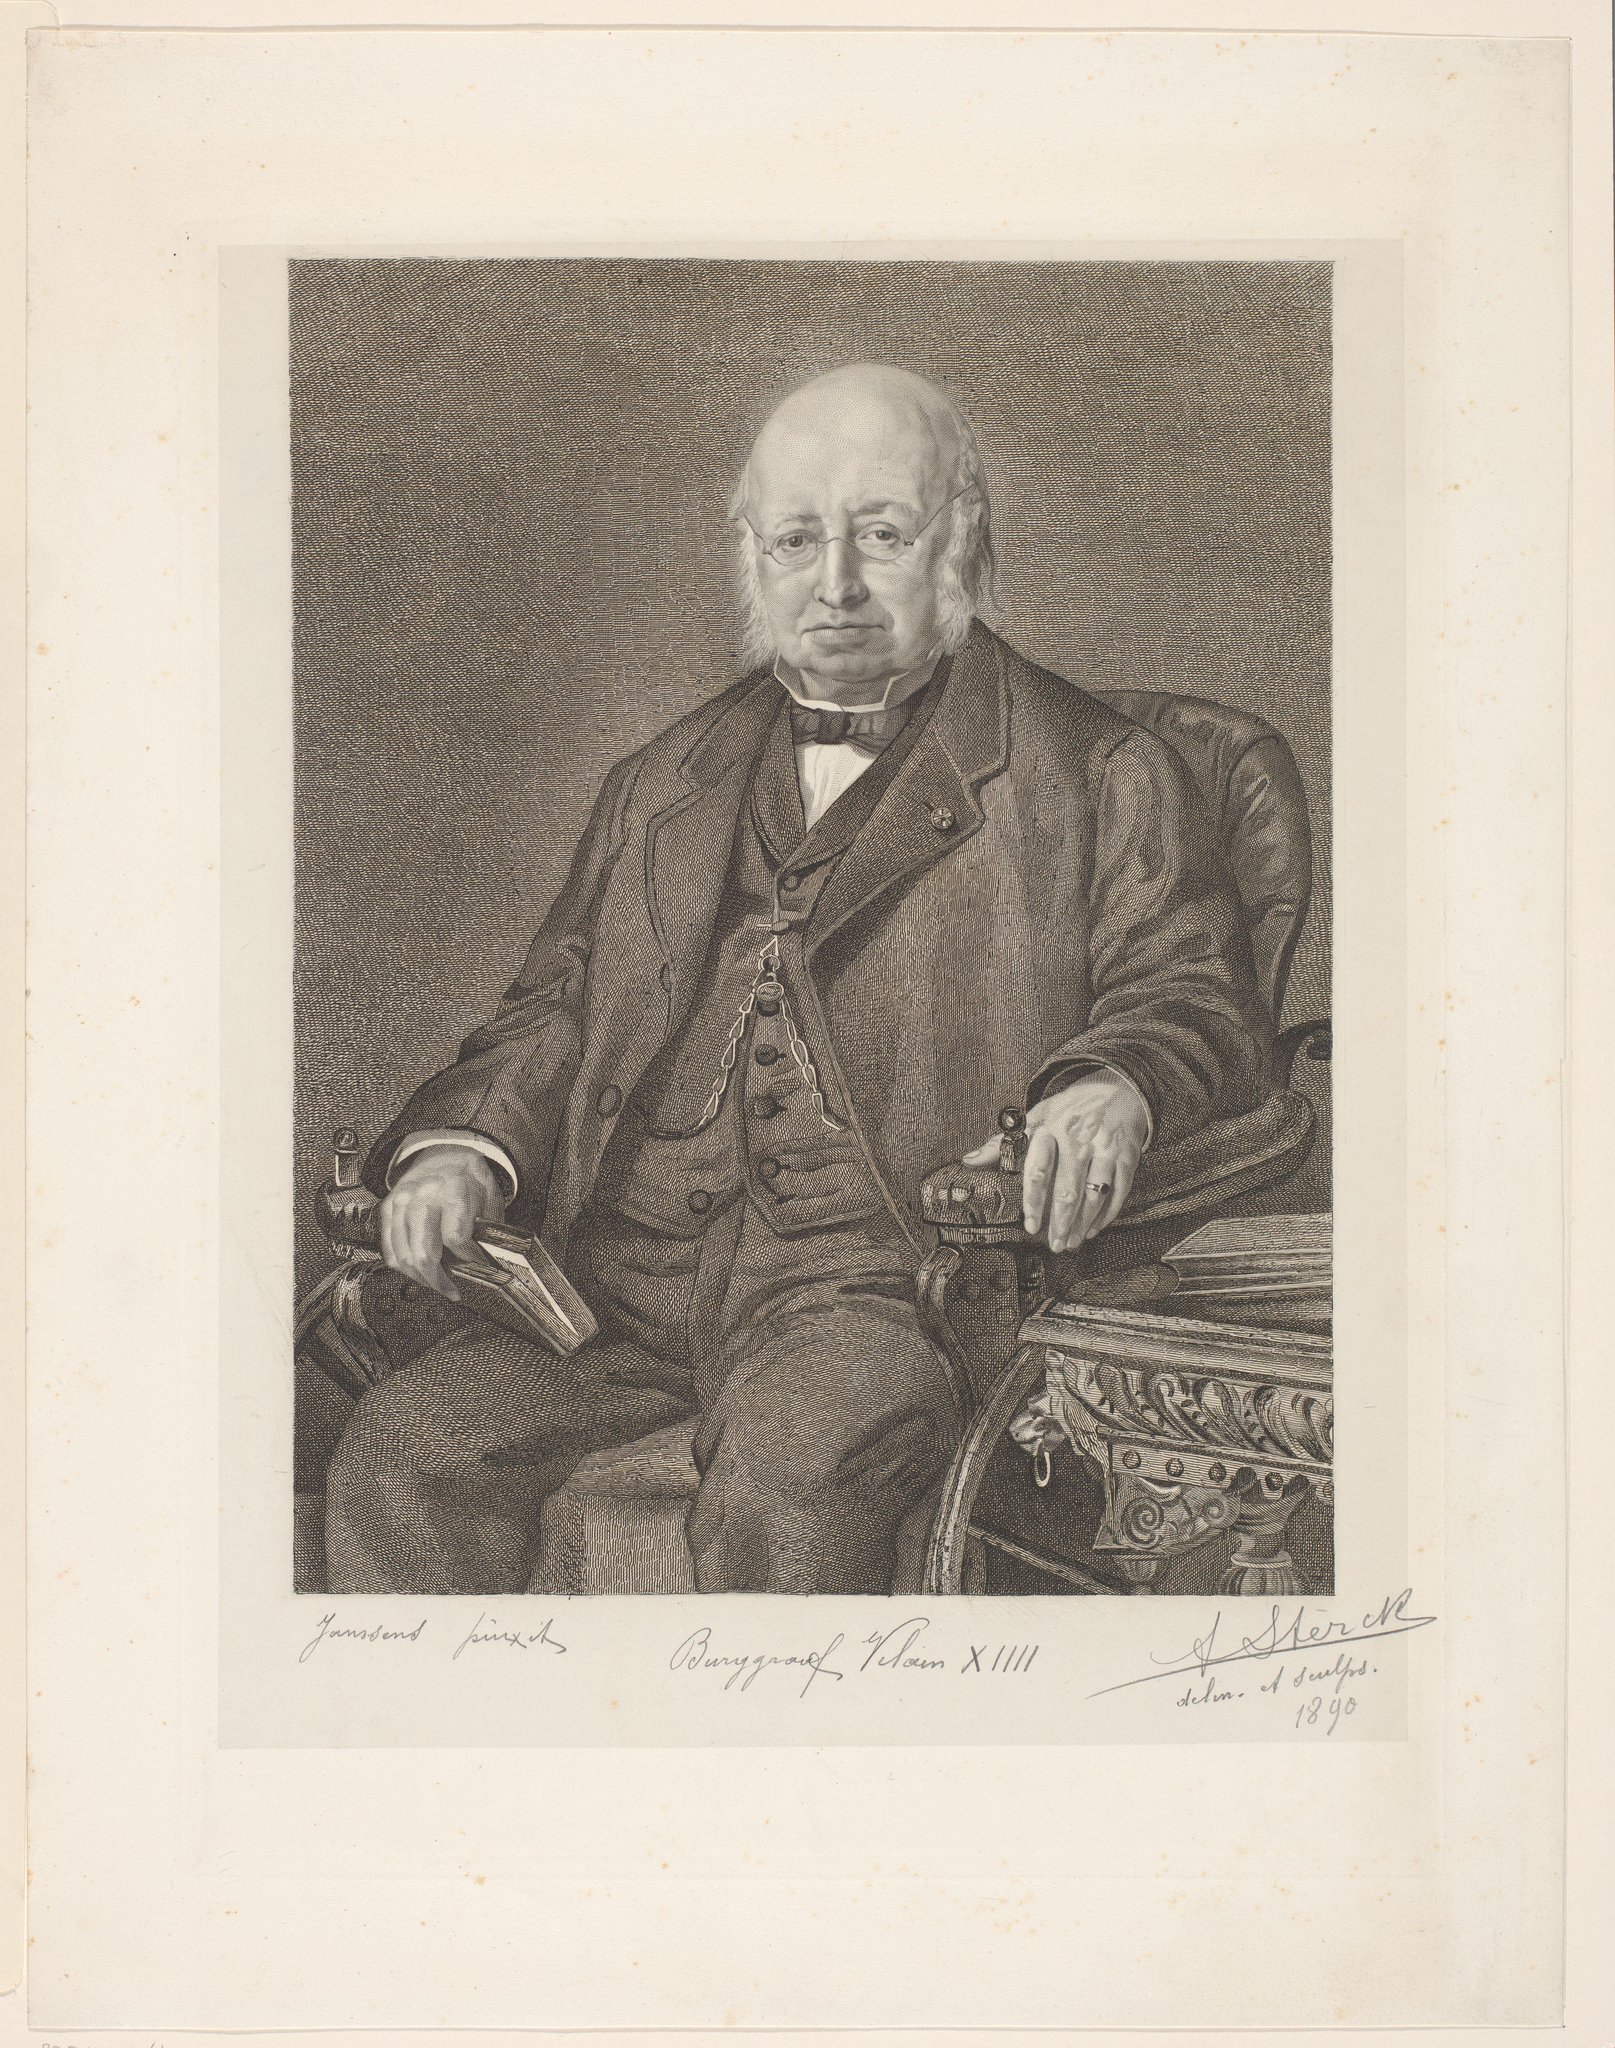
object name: print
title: Burggraaf Vilain XIIII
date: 1890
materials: paper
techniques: engraving, etching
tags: namur, brussels, politician, mayor, historical persons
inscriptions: collector's mark: Lugt 2228